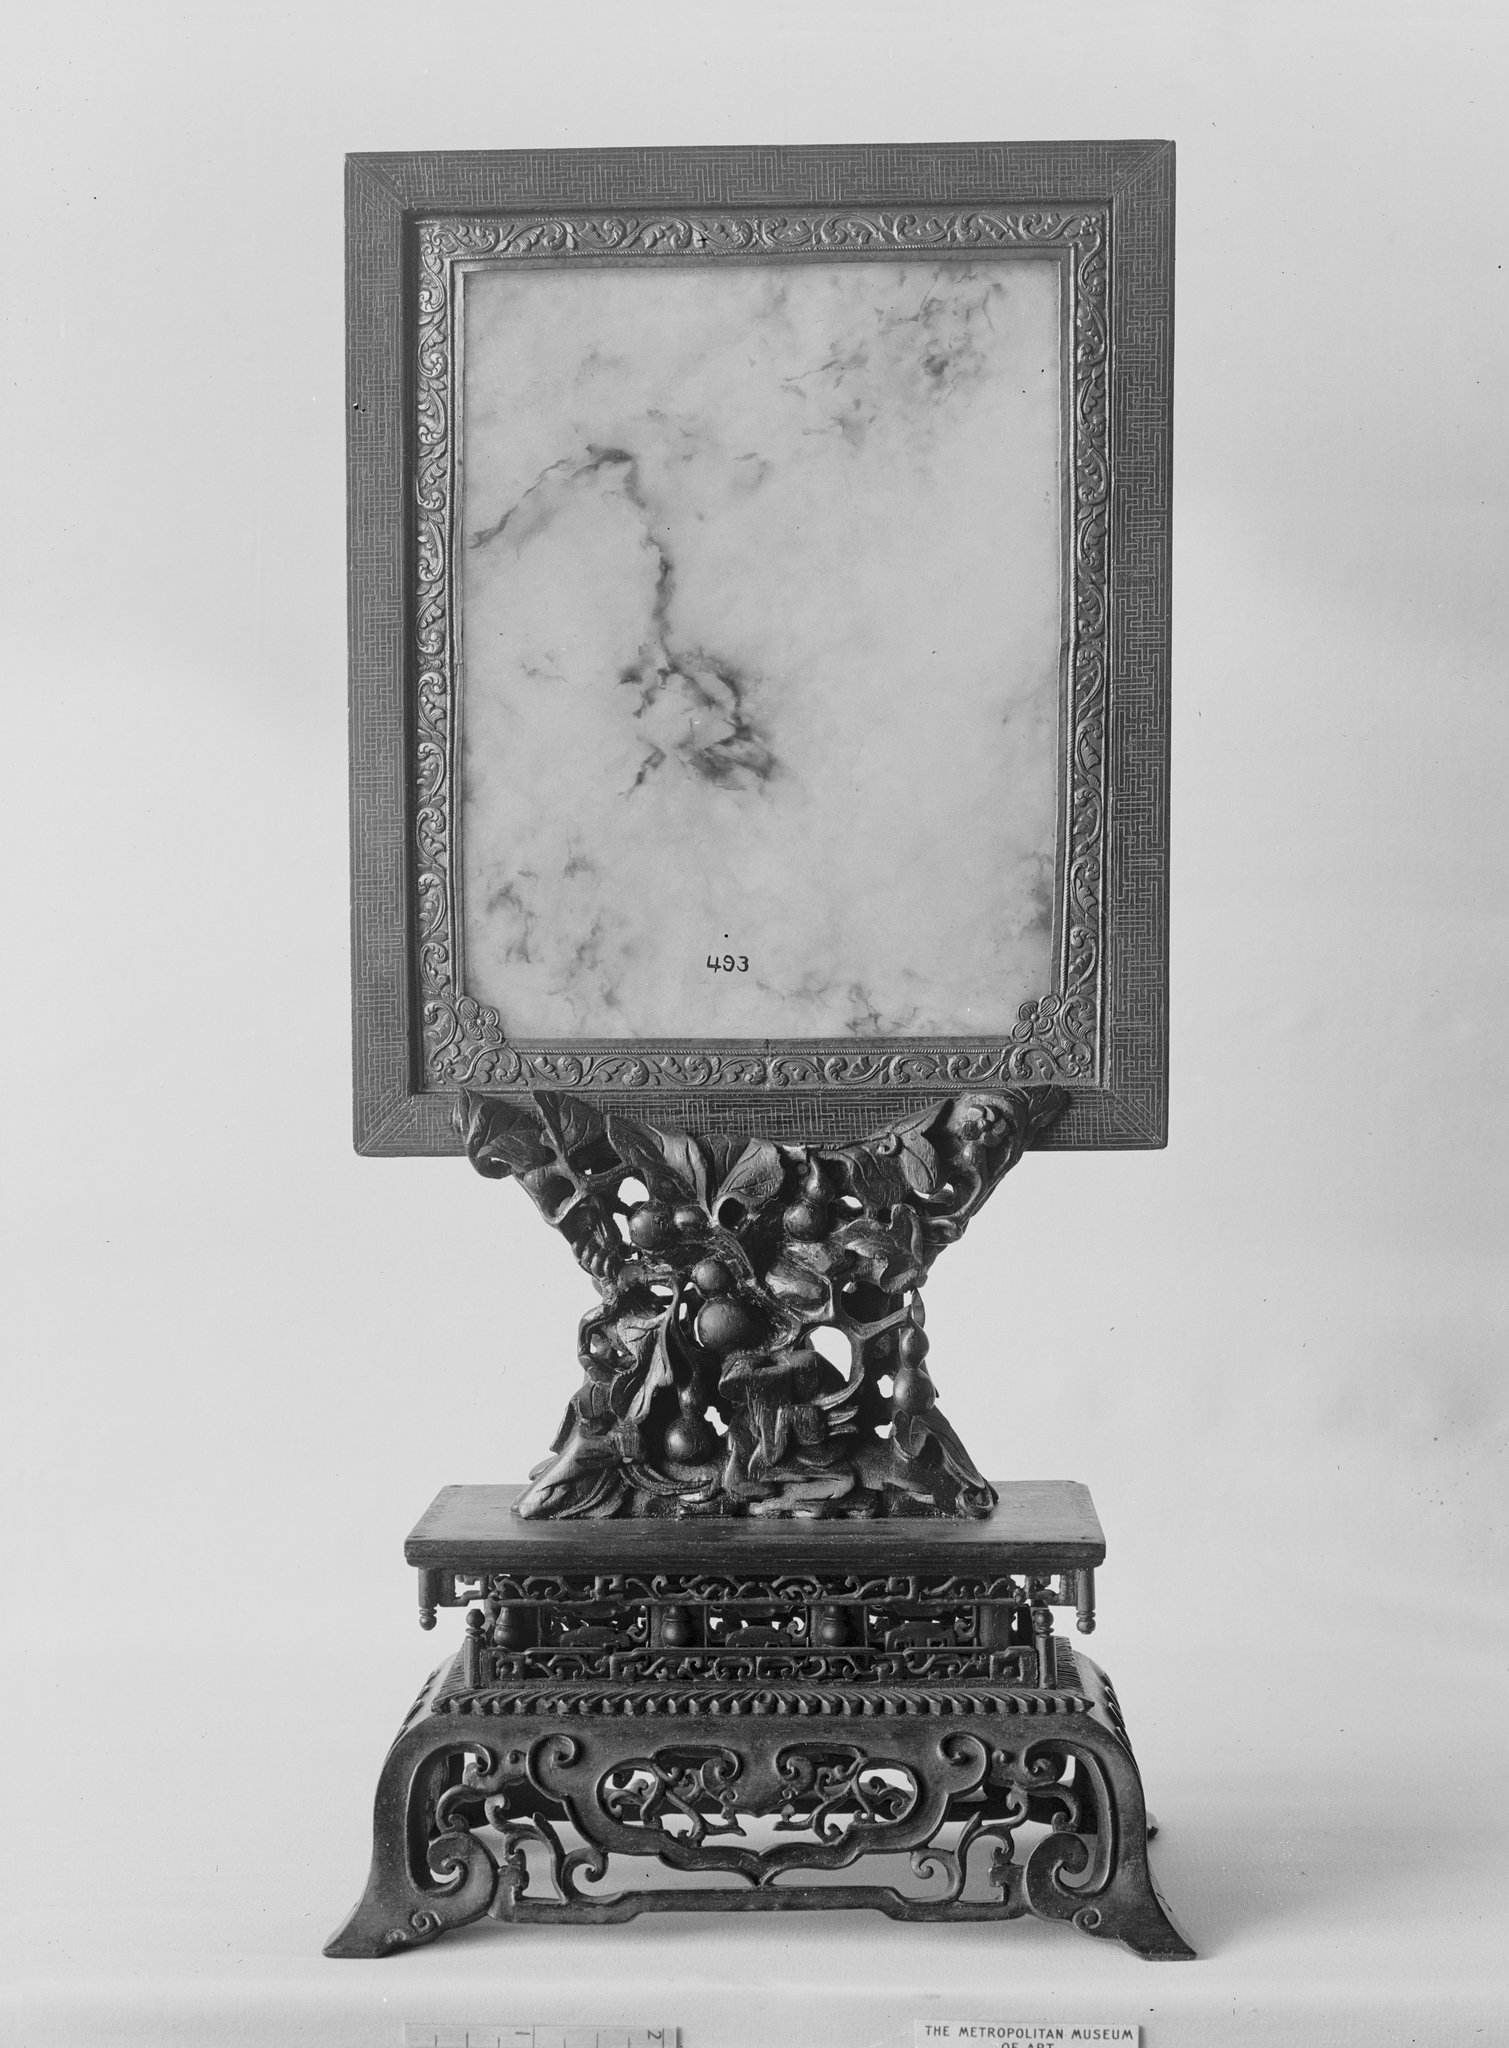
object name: table screen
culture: chinese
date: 1736-1795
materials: jade